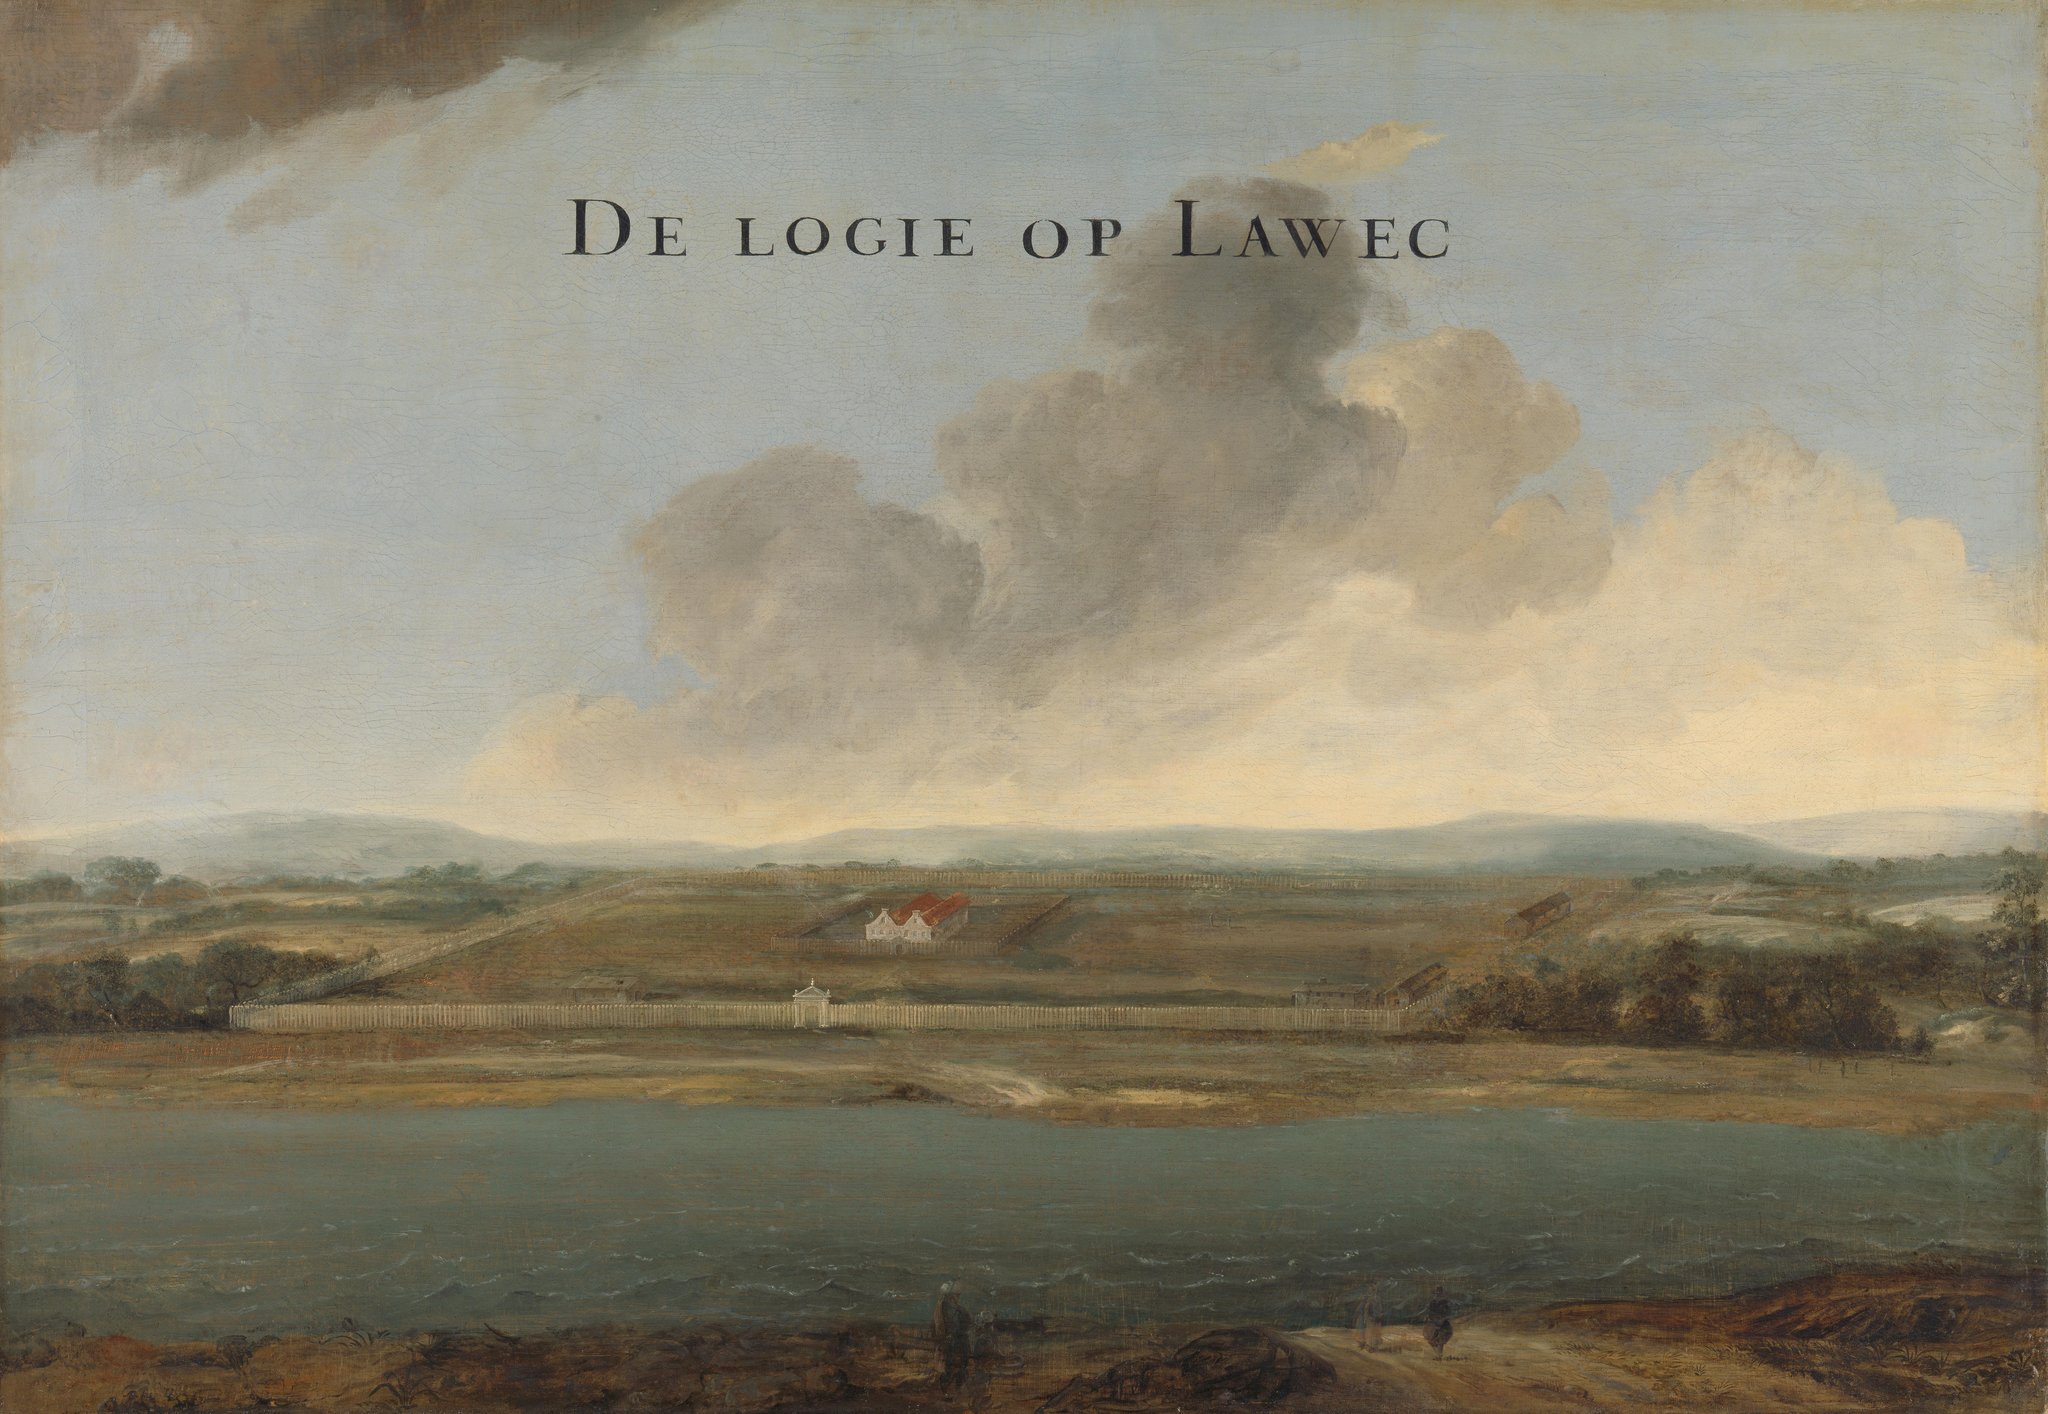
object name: painting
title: View of the Dutch Settlement at Lawec in Cambodia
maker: johannes vinckboons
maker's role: draughtsman, print maker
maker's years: 1616-1670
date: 1662-1663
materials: linen, oil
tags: river, locations for trading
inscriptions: inscription: ‘De Logie Op Lawec’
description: From 1609 the East India Company was sailing to Lawec, near Phnom Penh. There the company purchased provisions, such as rice, butter, pork, and lard, for Batavia. Banda supplied mace and nutmeg. In 1621, Governor-General Coen punished the island for trading with other countries: all fifteen thousand islanders were killed or driven away. The ‘slaughterer of Banda’ founded nutmeg parcels, heavily guarded by forts